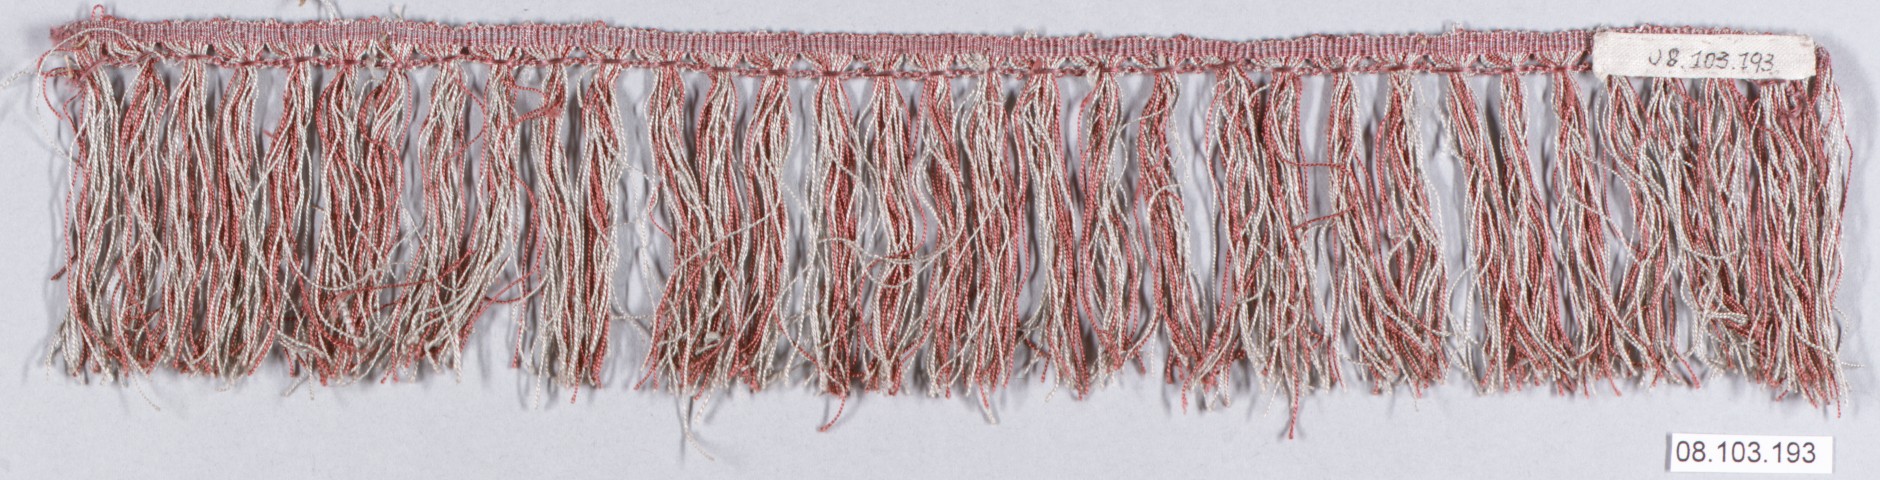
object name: fringe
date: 1701-1900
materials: silk